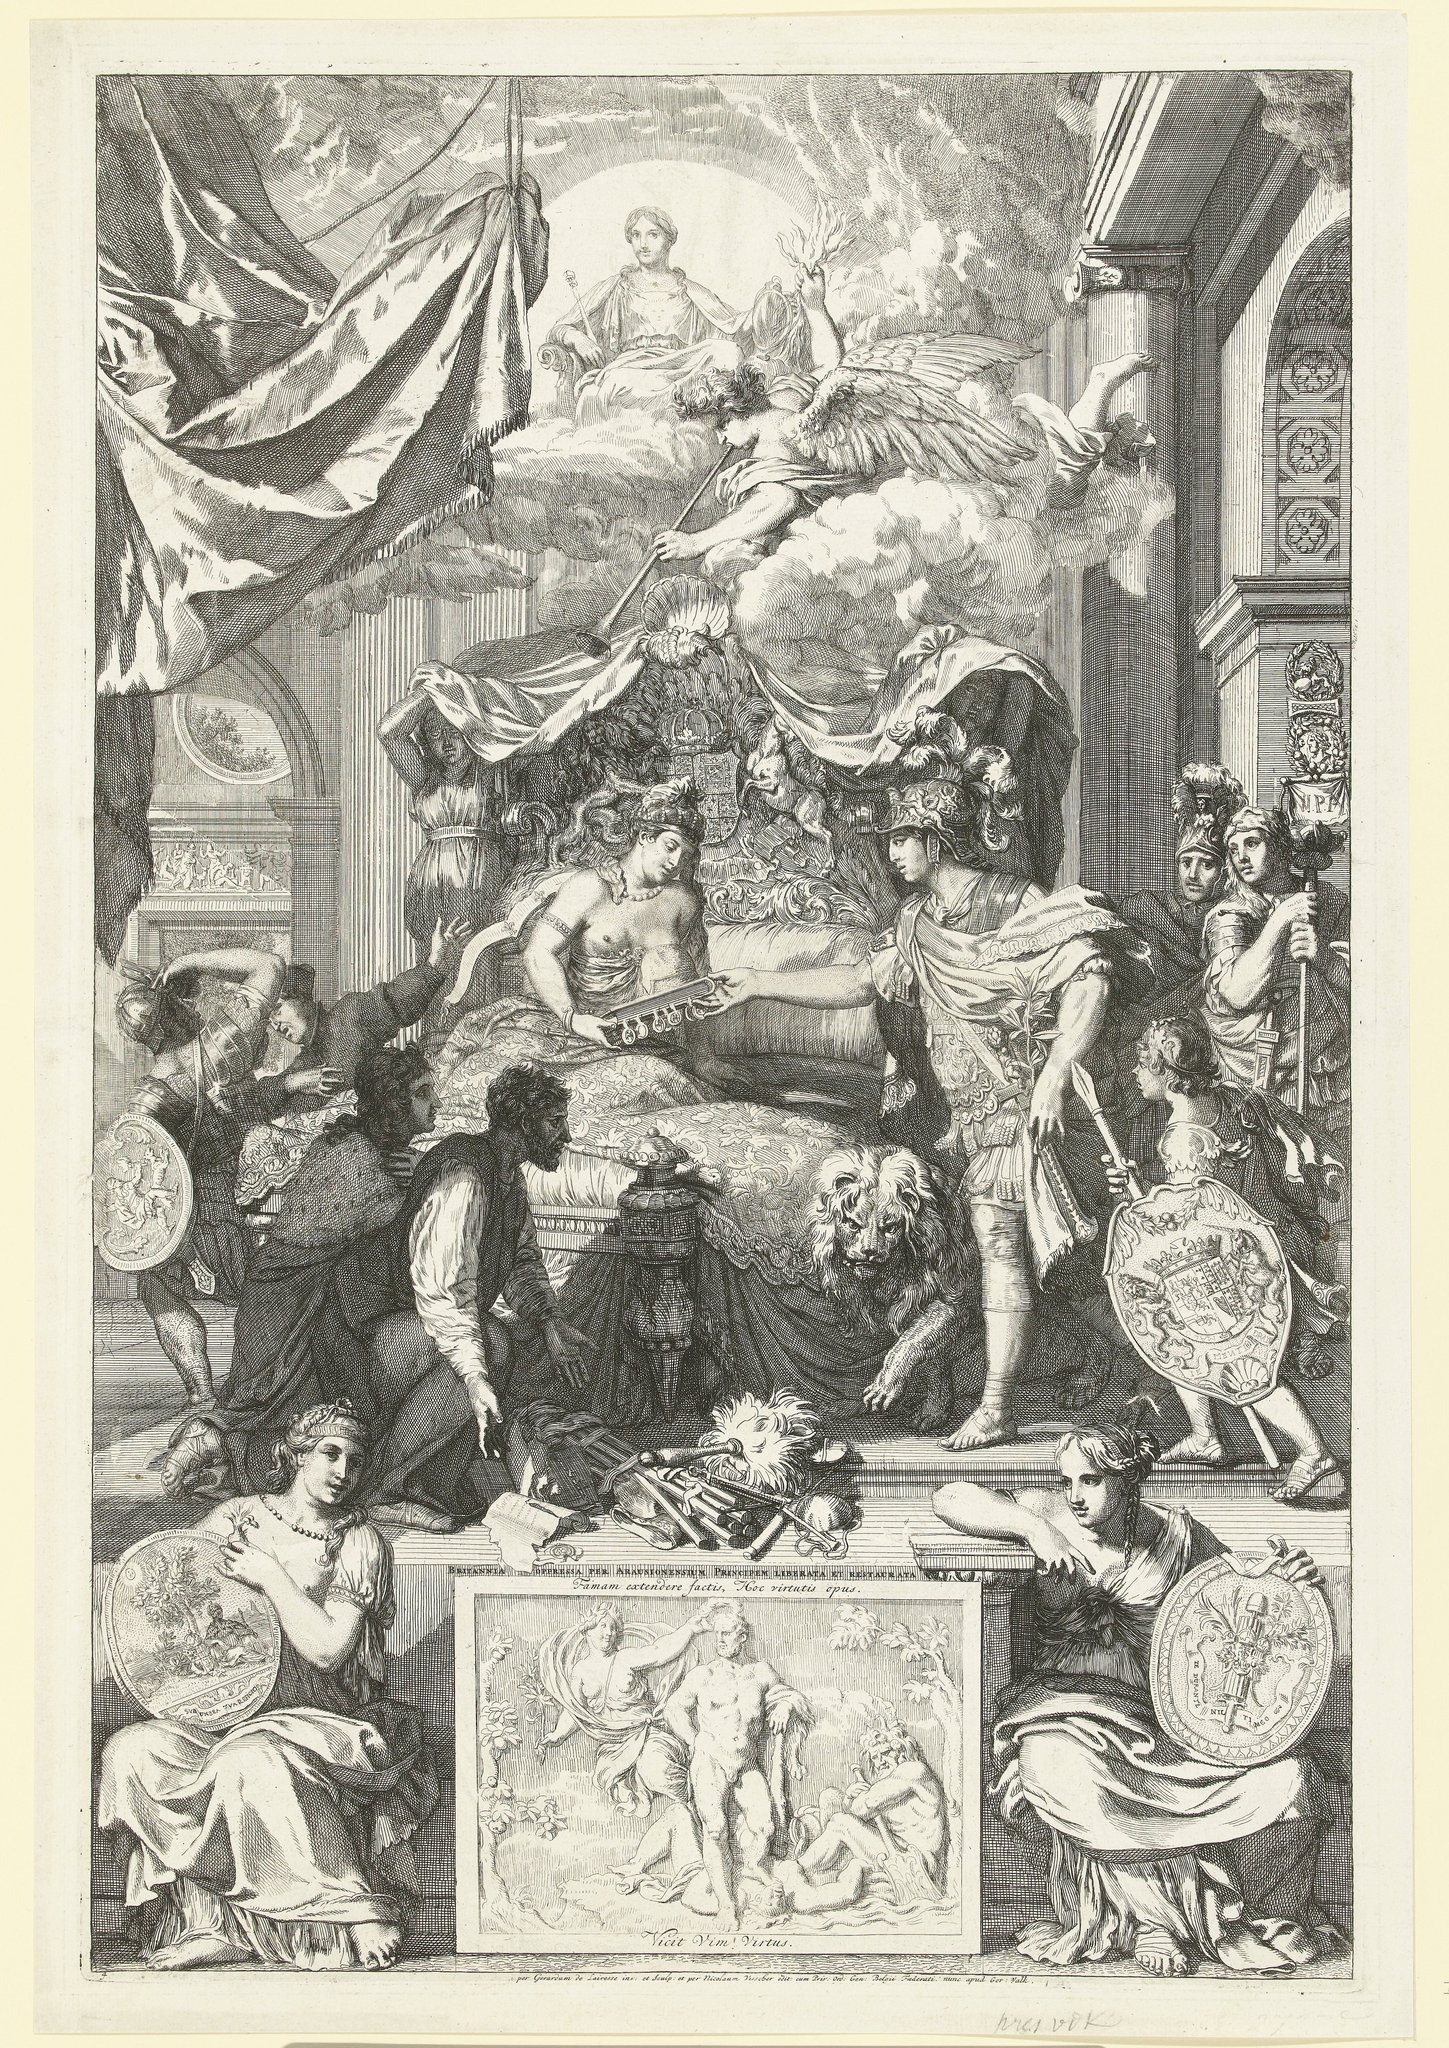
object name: propagandaprent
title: Britannia Opressa per Arausionensium Principem Liberata et Restaurata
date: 1688-1689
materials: paper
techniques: etching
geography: northern netherlands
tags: william iii (prince of orange and king of england, scotland, and ireland), personifications of countries, nations, states, districts, etc., truth; 'verità' (ripa), england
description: Allegorie op het herstel van de ware godsdienst in Engeland met de komst van de prins van Oranje, 1688. Allegorie waarin een romeinse veldheer, Willem III, vergezeld van de Hollandse Leeuw een verzegelde bijbel overhandigt aan de Engelse Maagd, door haar heer verlaten liggend in bed. Aan het voeteneind knielen de Engelse lord en burger. In de lucht de engel van de wraak Gods met bliksemschichten en bazuin en de tronende Waarheid. Op de voorgrond twee vrouwenfiguren zittend aan weerszijden van een fries met een voorstelling van Hercules gekroond. Genummerd linksonder: 4.